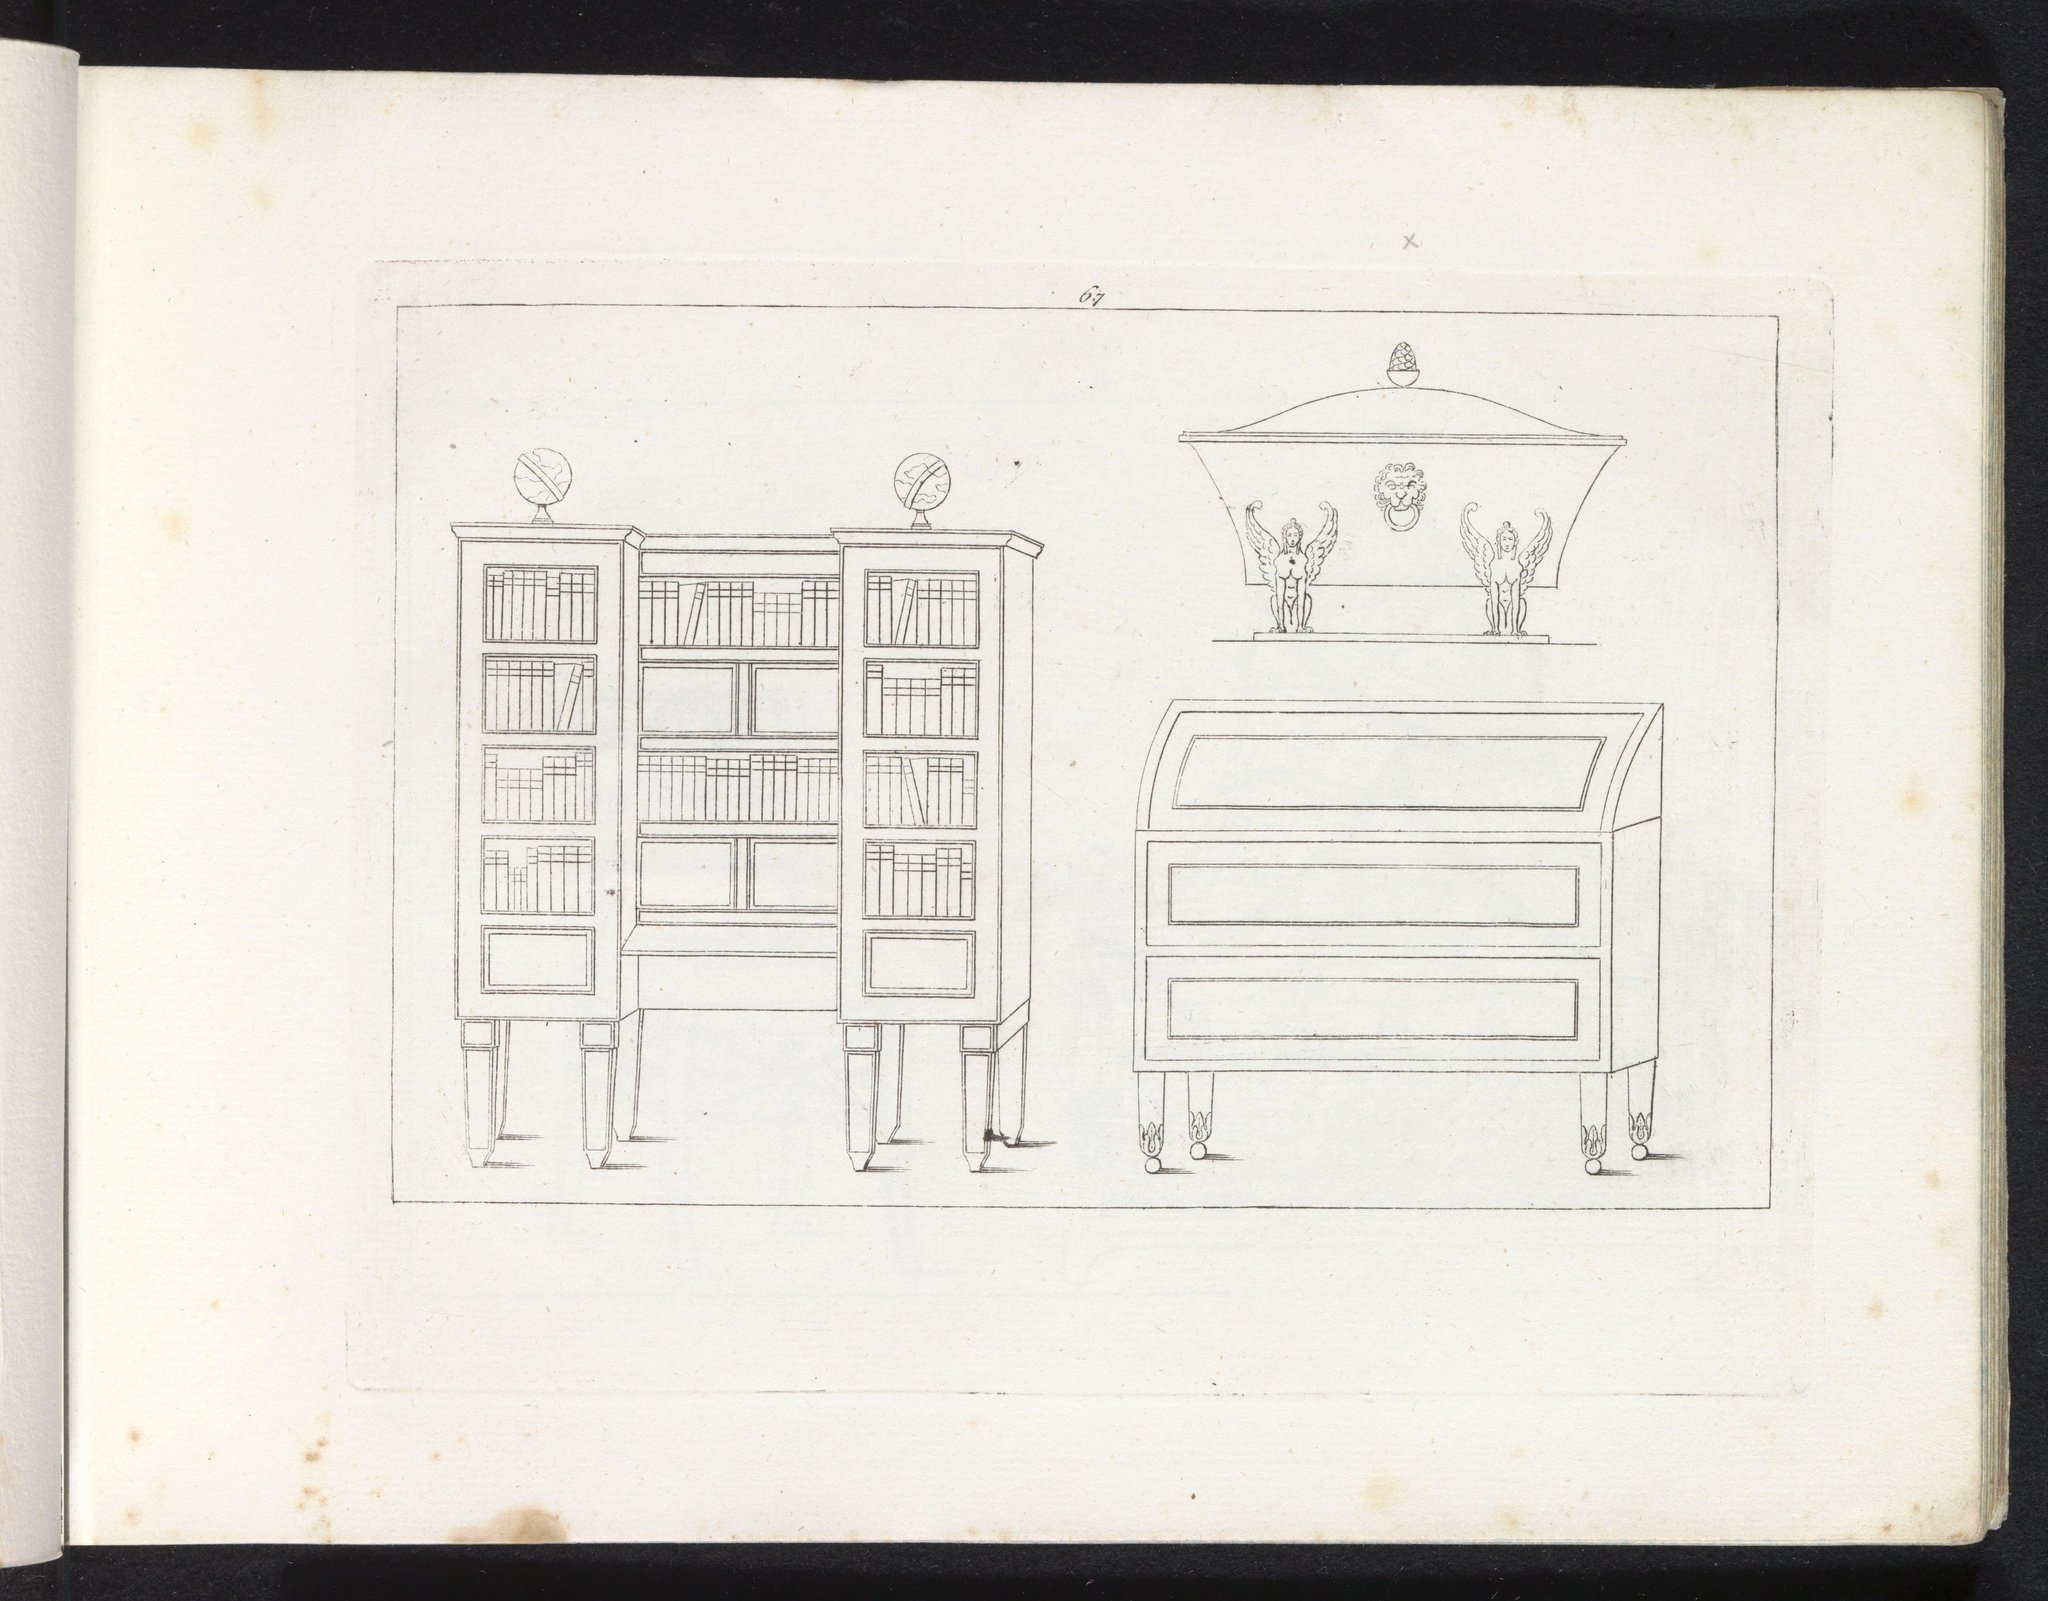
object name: print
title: Ontwerpen voor religieuze en profane voorwerpen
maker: pietro ruga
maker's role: print maker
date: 1817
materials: paper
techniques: etching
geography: milan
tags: ornamental cupboard, ornaments ~ art, bowl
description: Prent maakt deel uit van een reeks van 100 prenten (+ titelprent) met ontwerpen voor religieuze en profane voorwerpen.